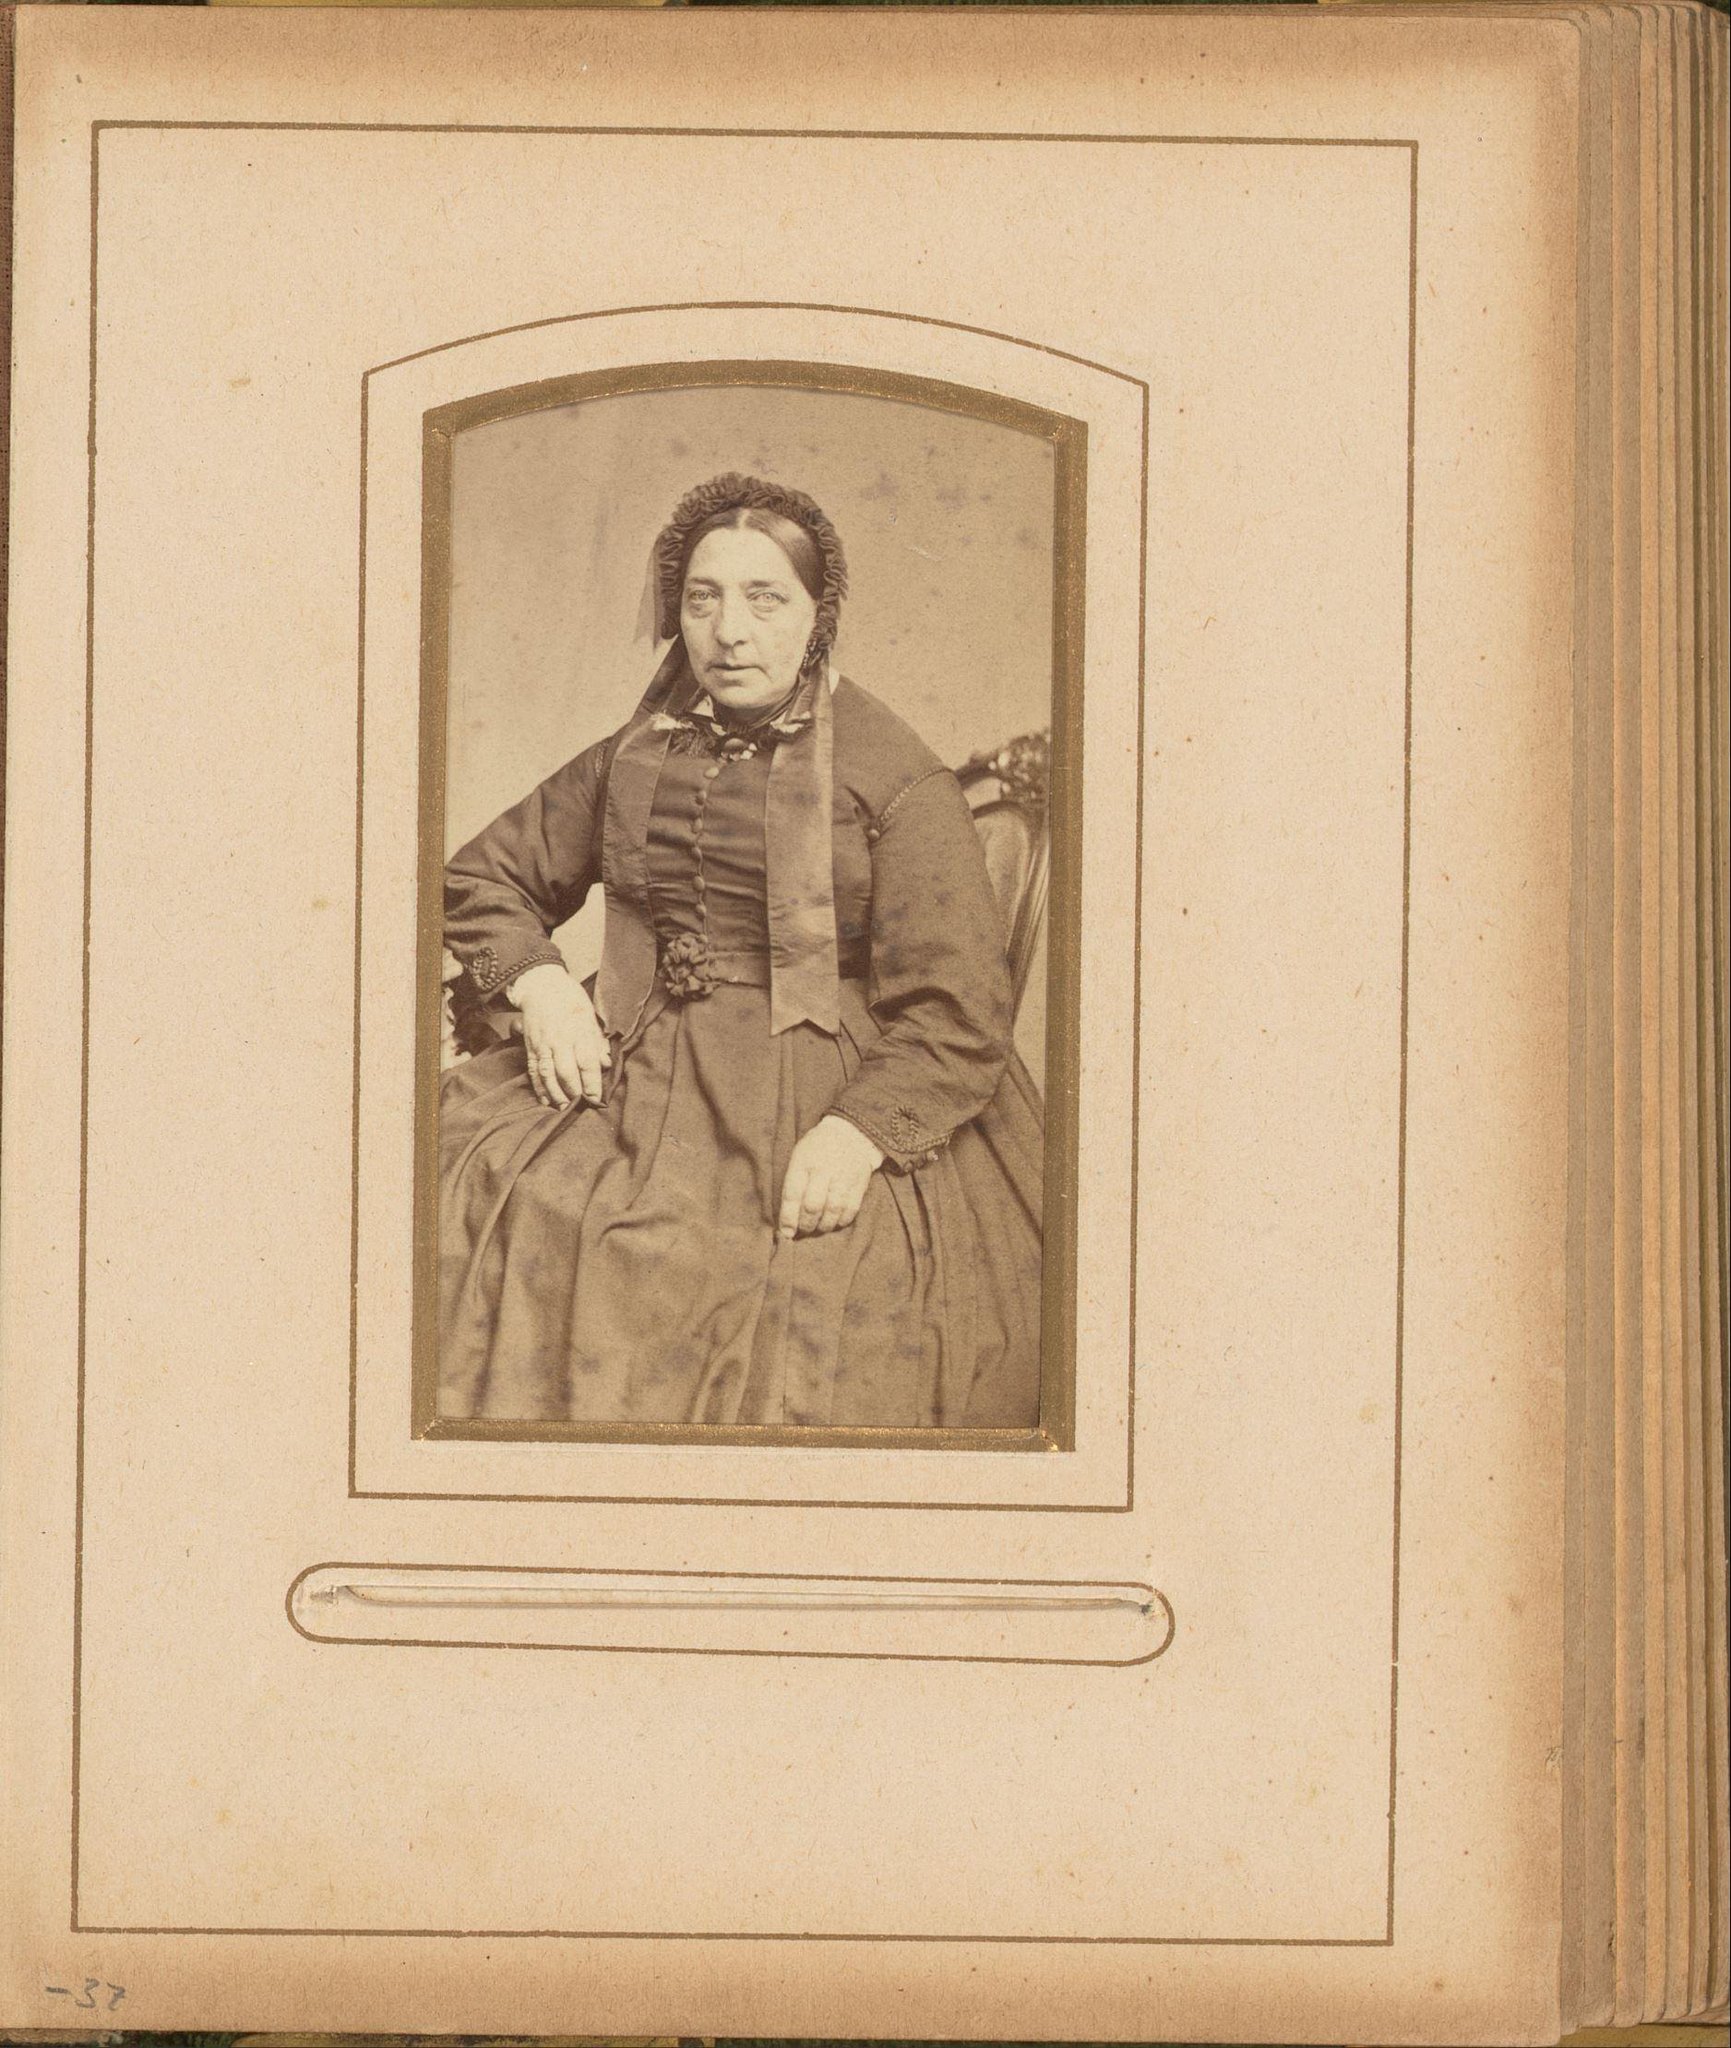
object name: photograph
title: Portret van een vrouw, mogelijk lid van de familie Beucker Andreae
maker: Anonymous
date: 1854-1885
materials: cardboard, paper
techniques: albumen print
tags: adult woman, anonymous historical person portrayed